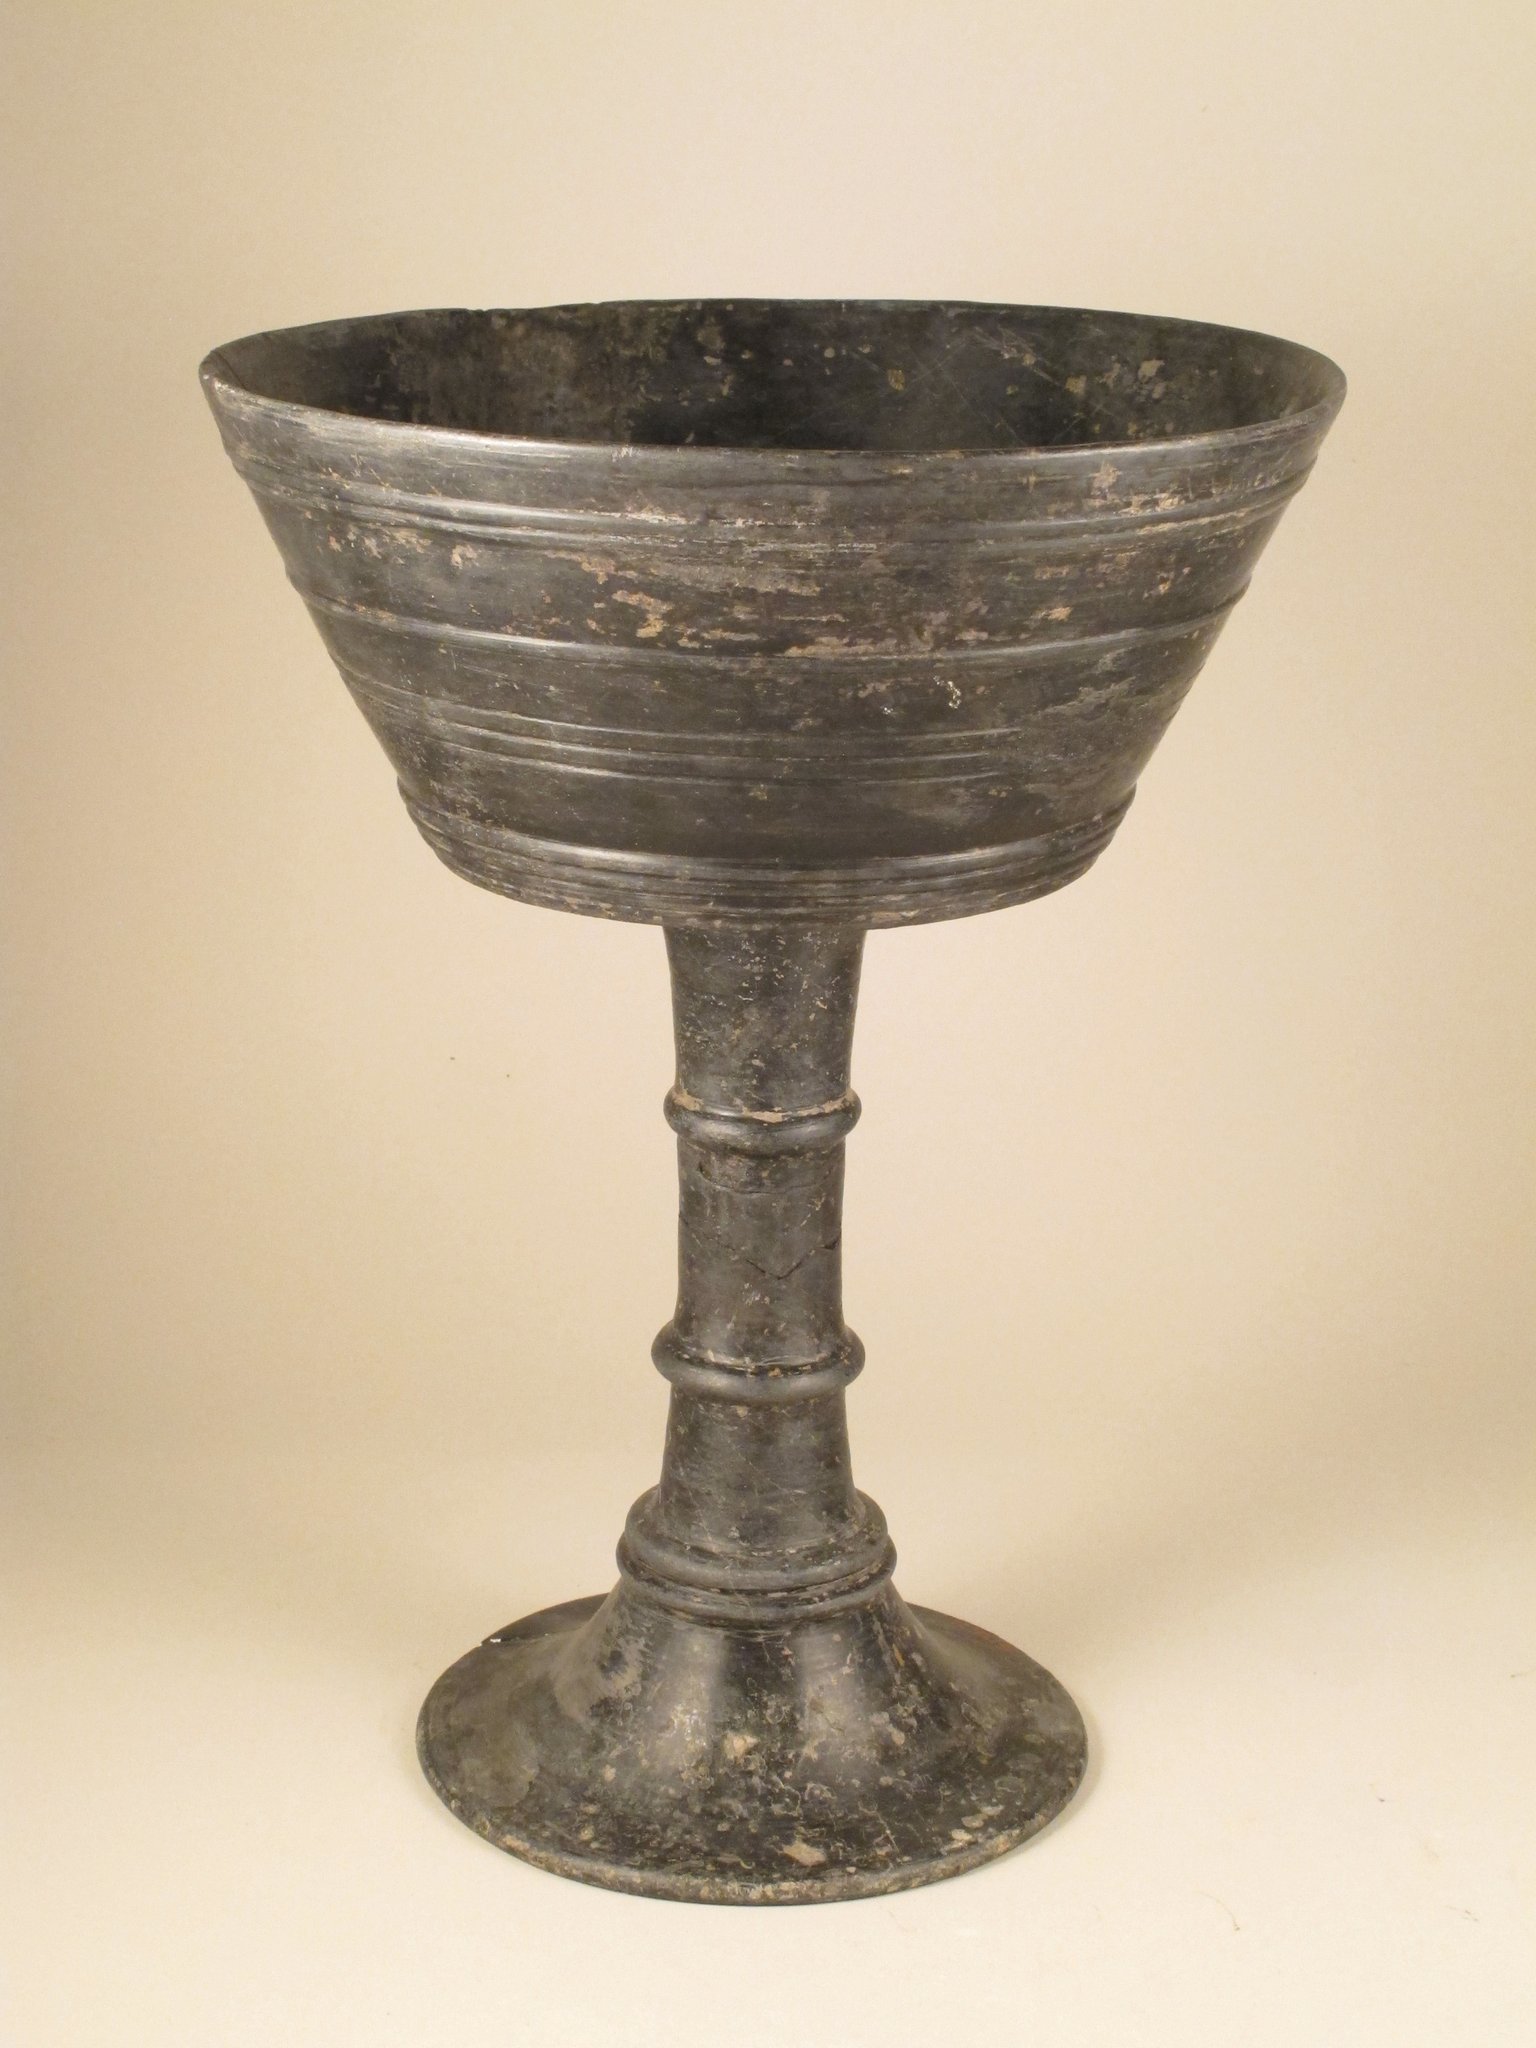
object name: cup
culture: etruscan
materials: terracotta